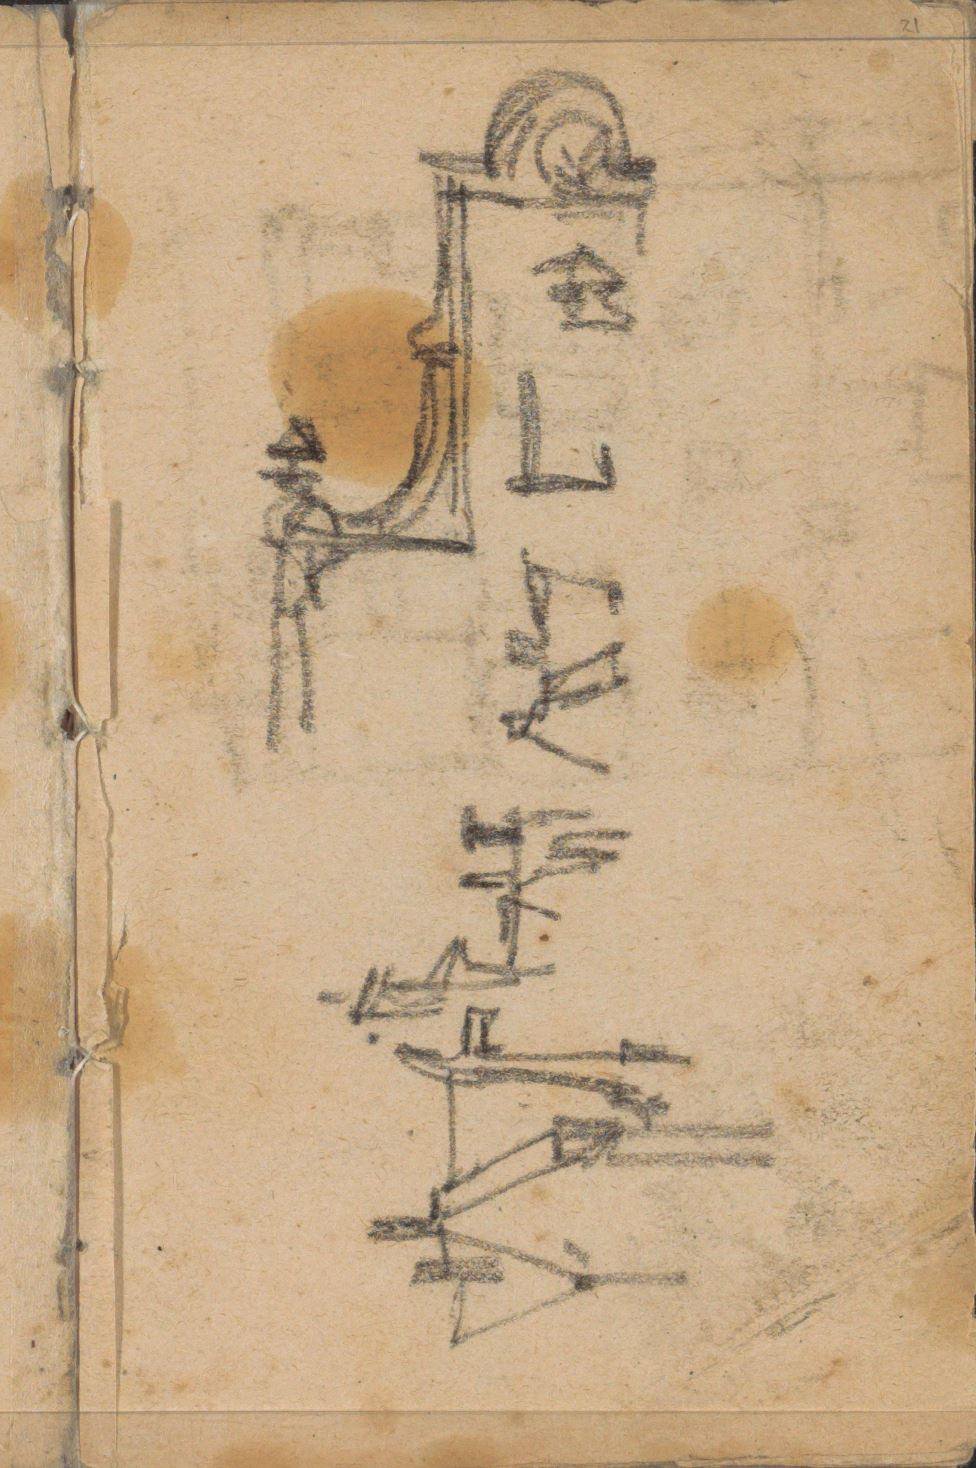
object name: sketchbook leaf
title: Rij gebouwen en een gevel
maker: george hendrik breitner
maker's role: draughtsman, painter, print maker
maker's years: 1857-1923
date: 1881-1883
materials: chalk, paper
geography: south holland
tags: urban housing, façade (of house or building)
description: Rij gebouwen en een gevel. Pagina 21 uit een schetsboek met 43 bladen.